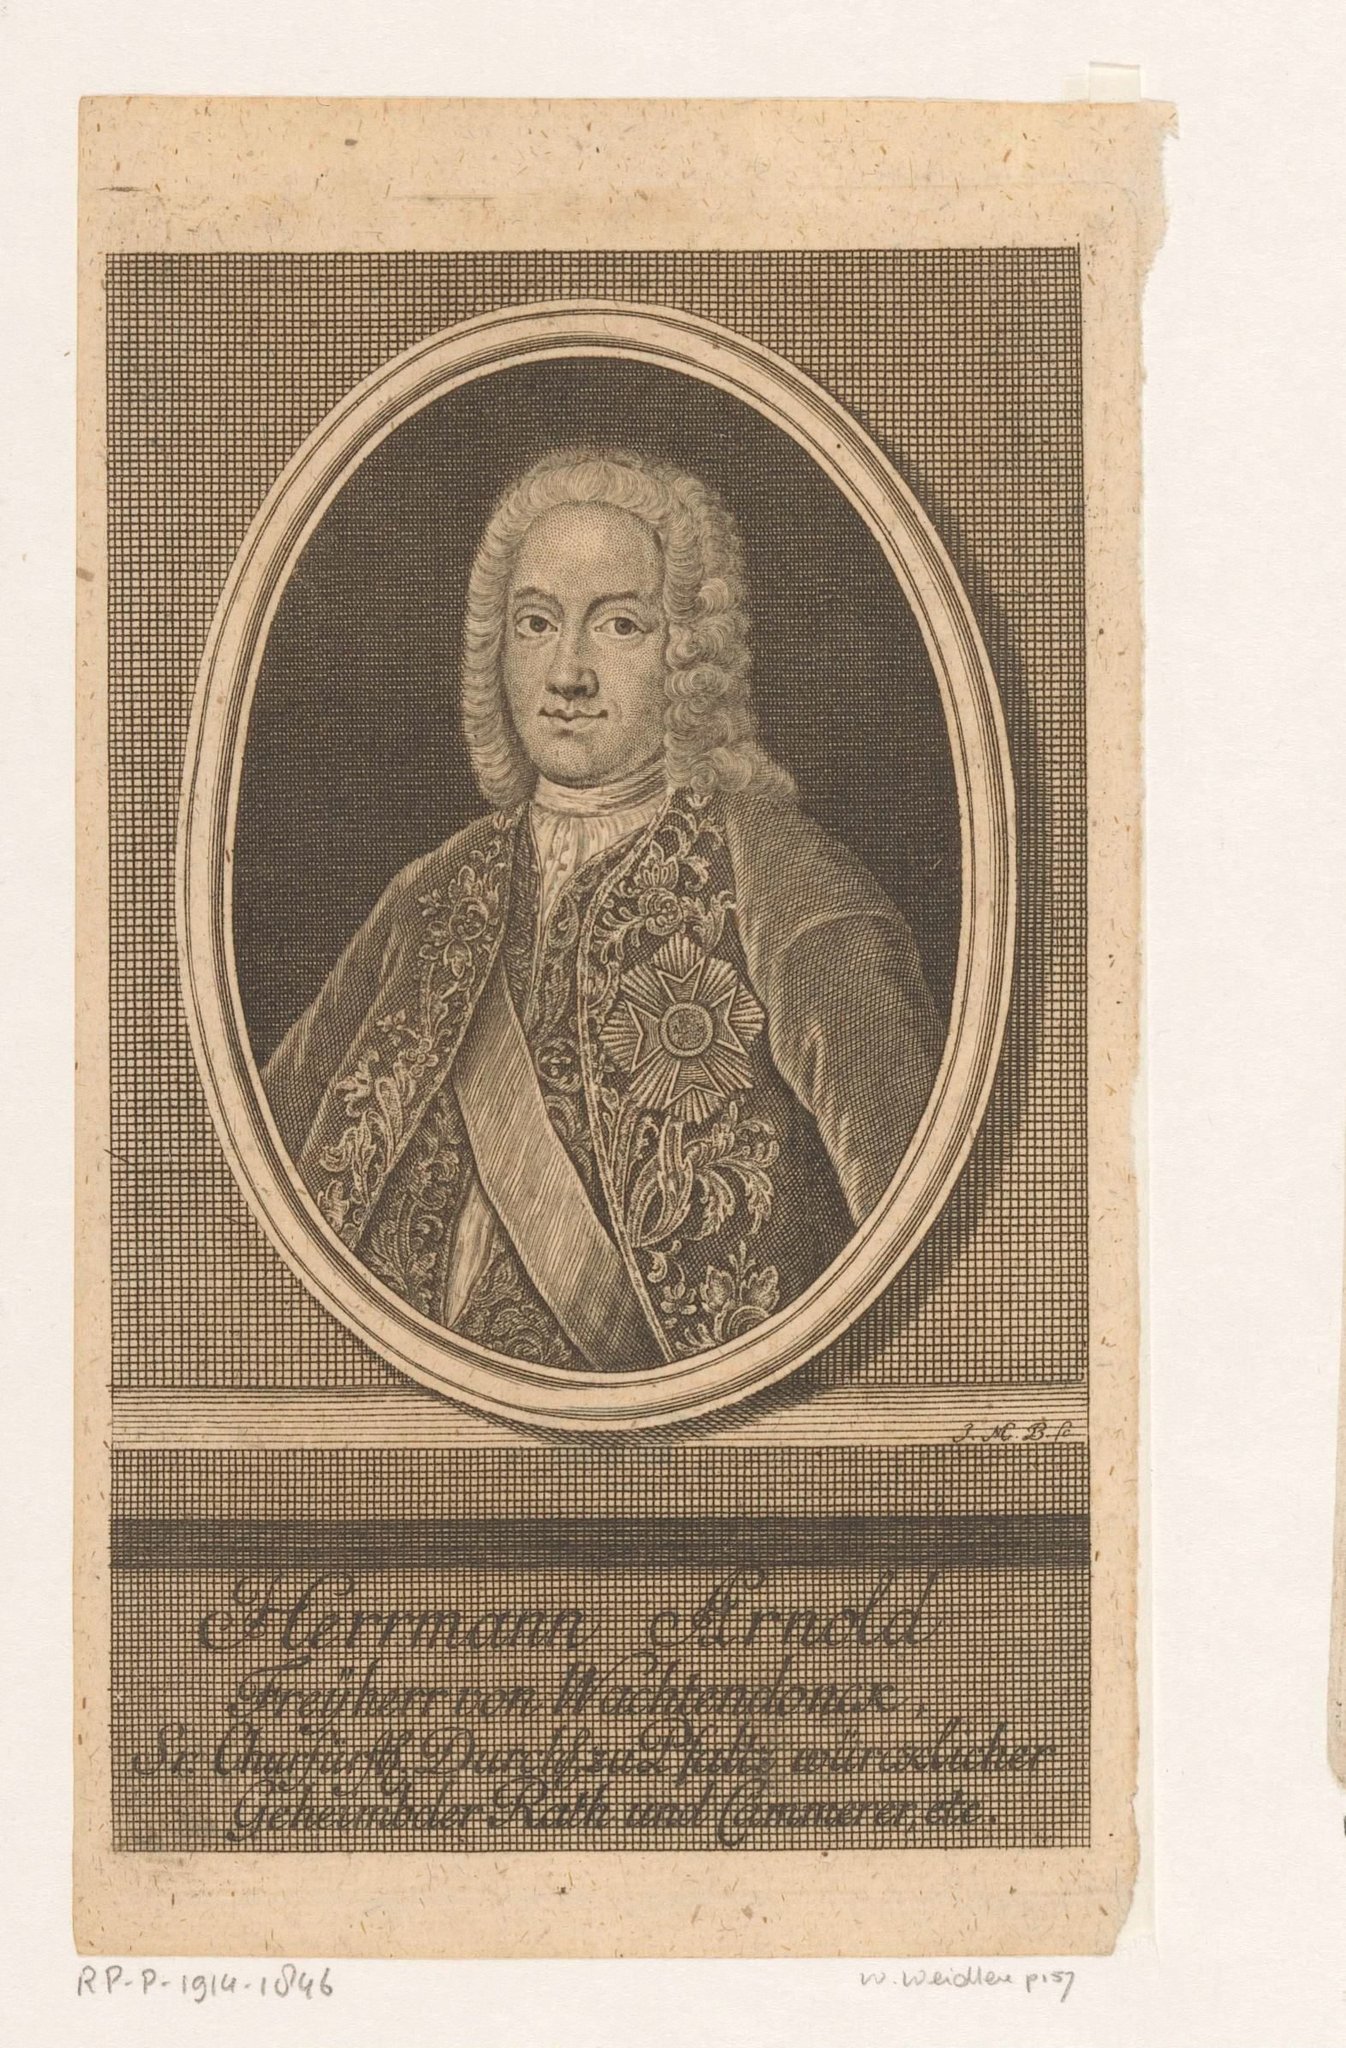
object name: print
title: Portret van Herrmann Arnold Freiherr von Wachtendonck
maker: johann martin bernigeroth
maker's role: print maker, publisher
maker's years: 1713-1767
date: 1745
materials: paper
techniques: engraving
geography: leipzig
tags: knighthood order, historical persons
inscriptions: collector's mark: Lugt 2228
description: Prent ook gebruikt in: Die Neue Europäische Fama, Welche den gegenwärtigen Zustand der vornehmsten Höfe entdecket. dl. 125. Leipzig: Gleditsch, 1745.